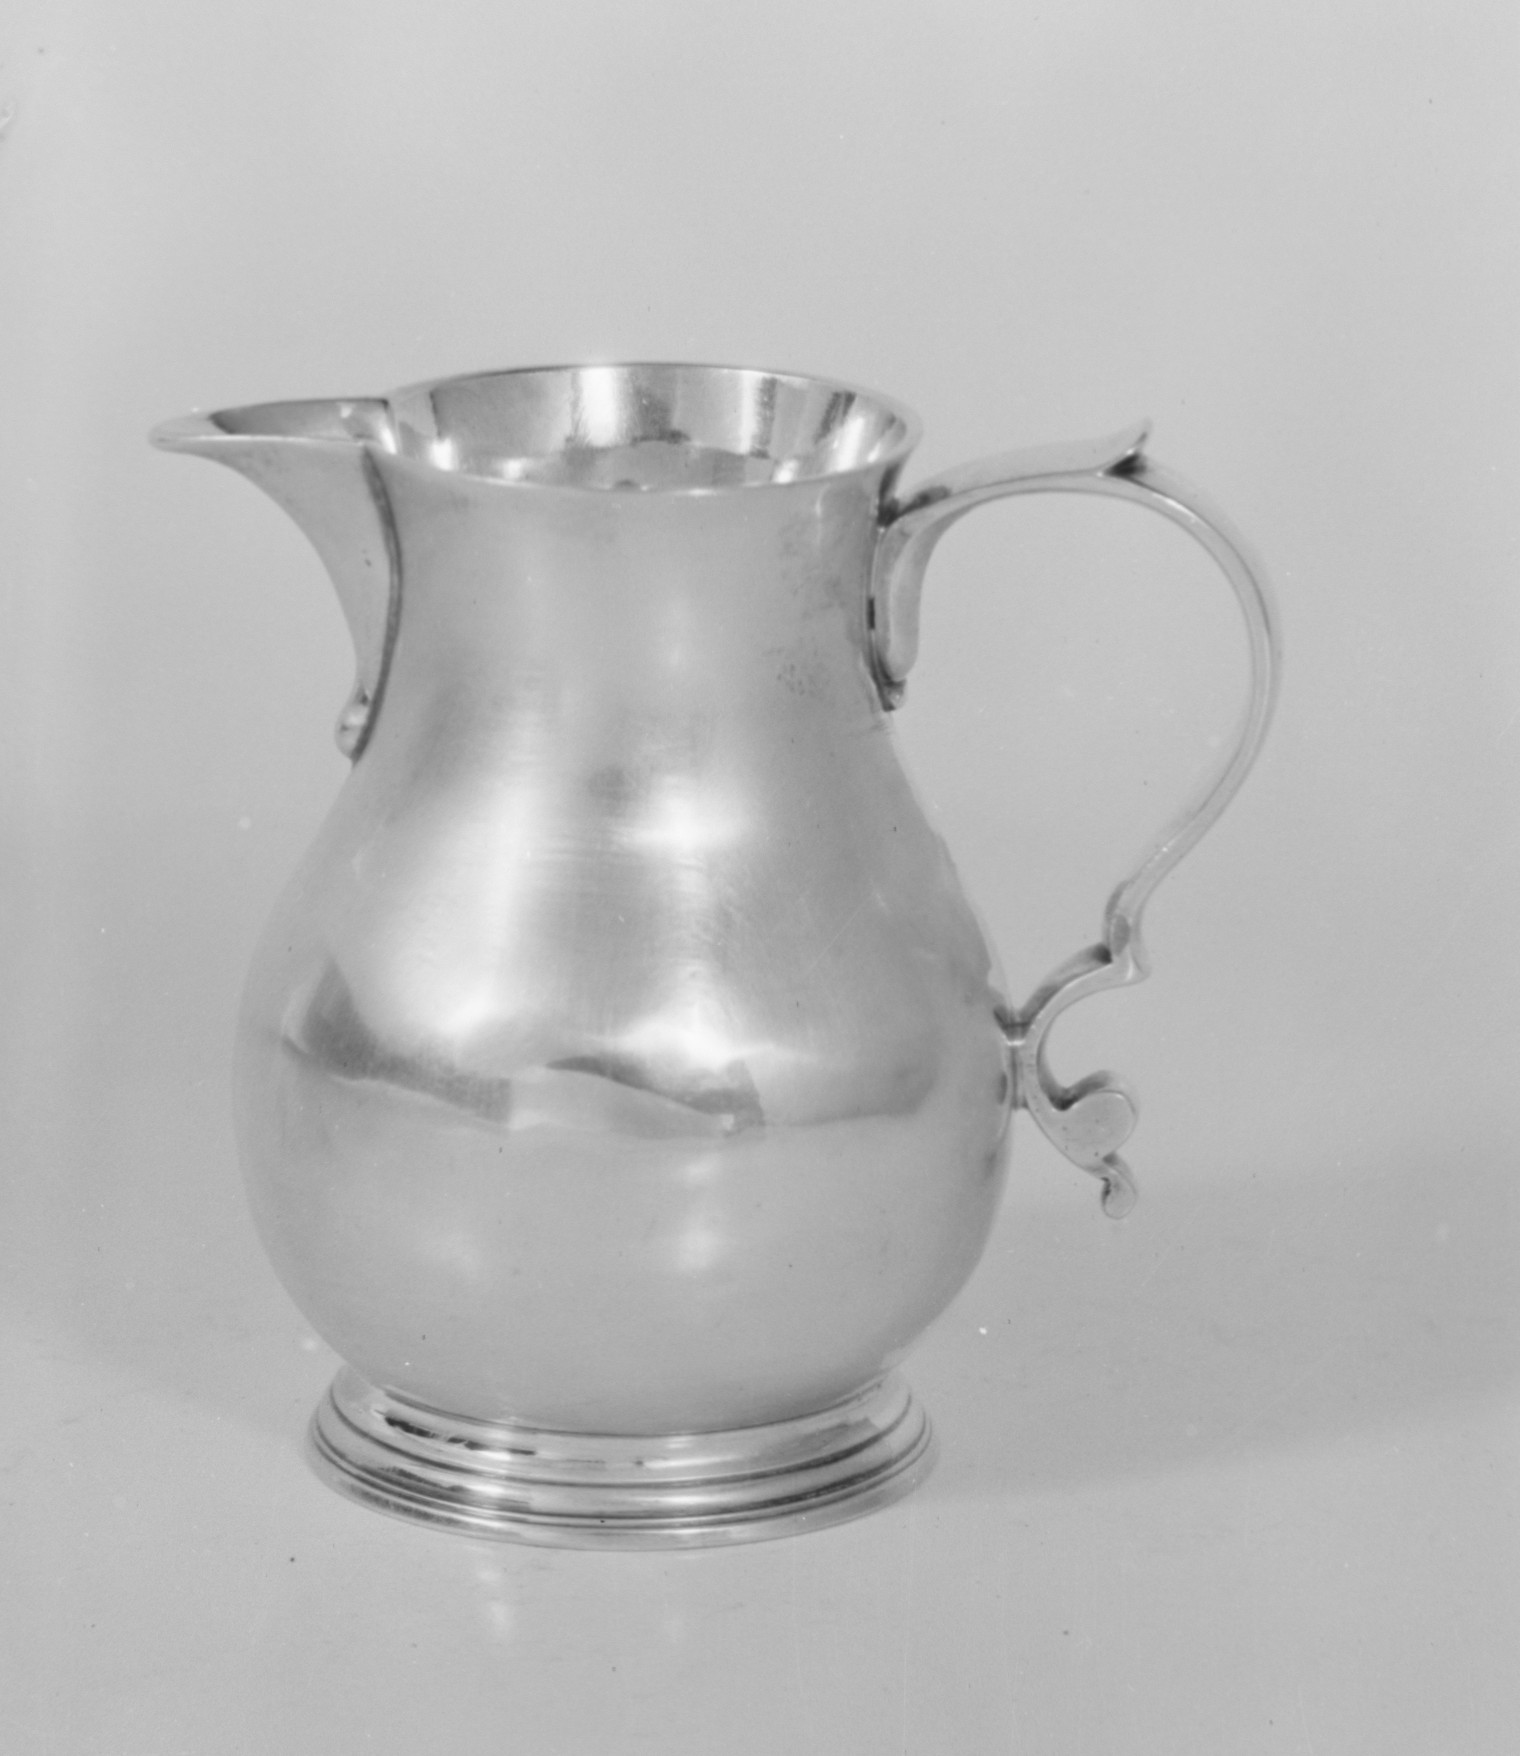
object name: cream jug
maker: john gamon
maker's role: maker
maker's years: 1727-1740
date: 1729-1730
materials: silver